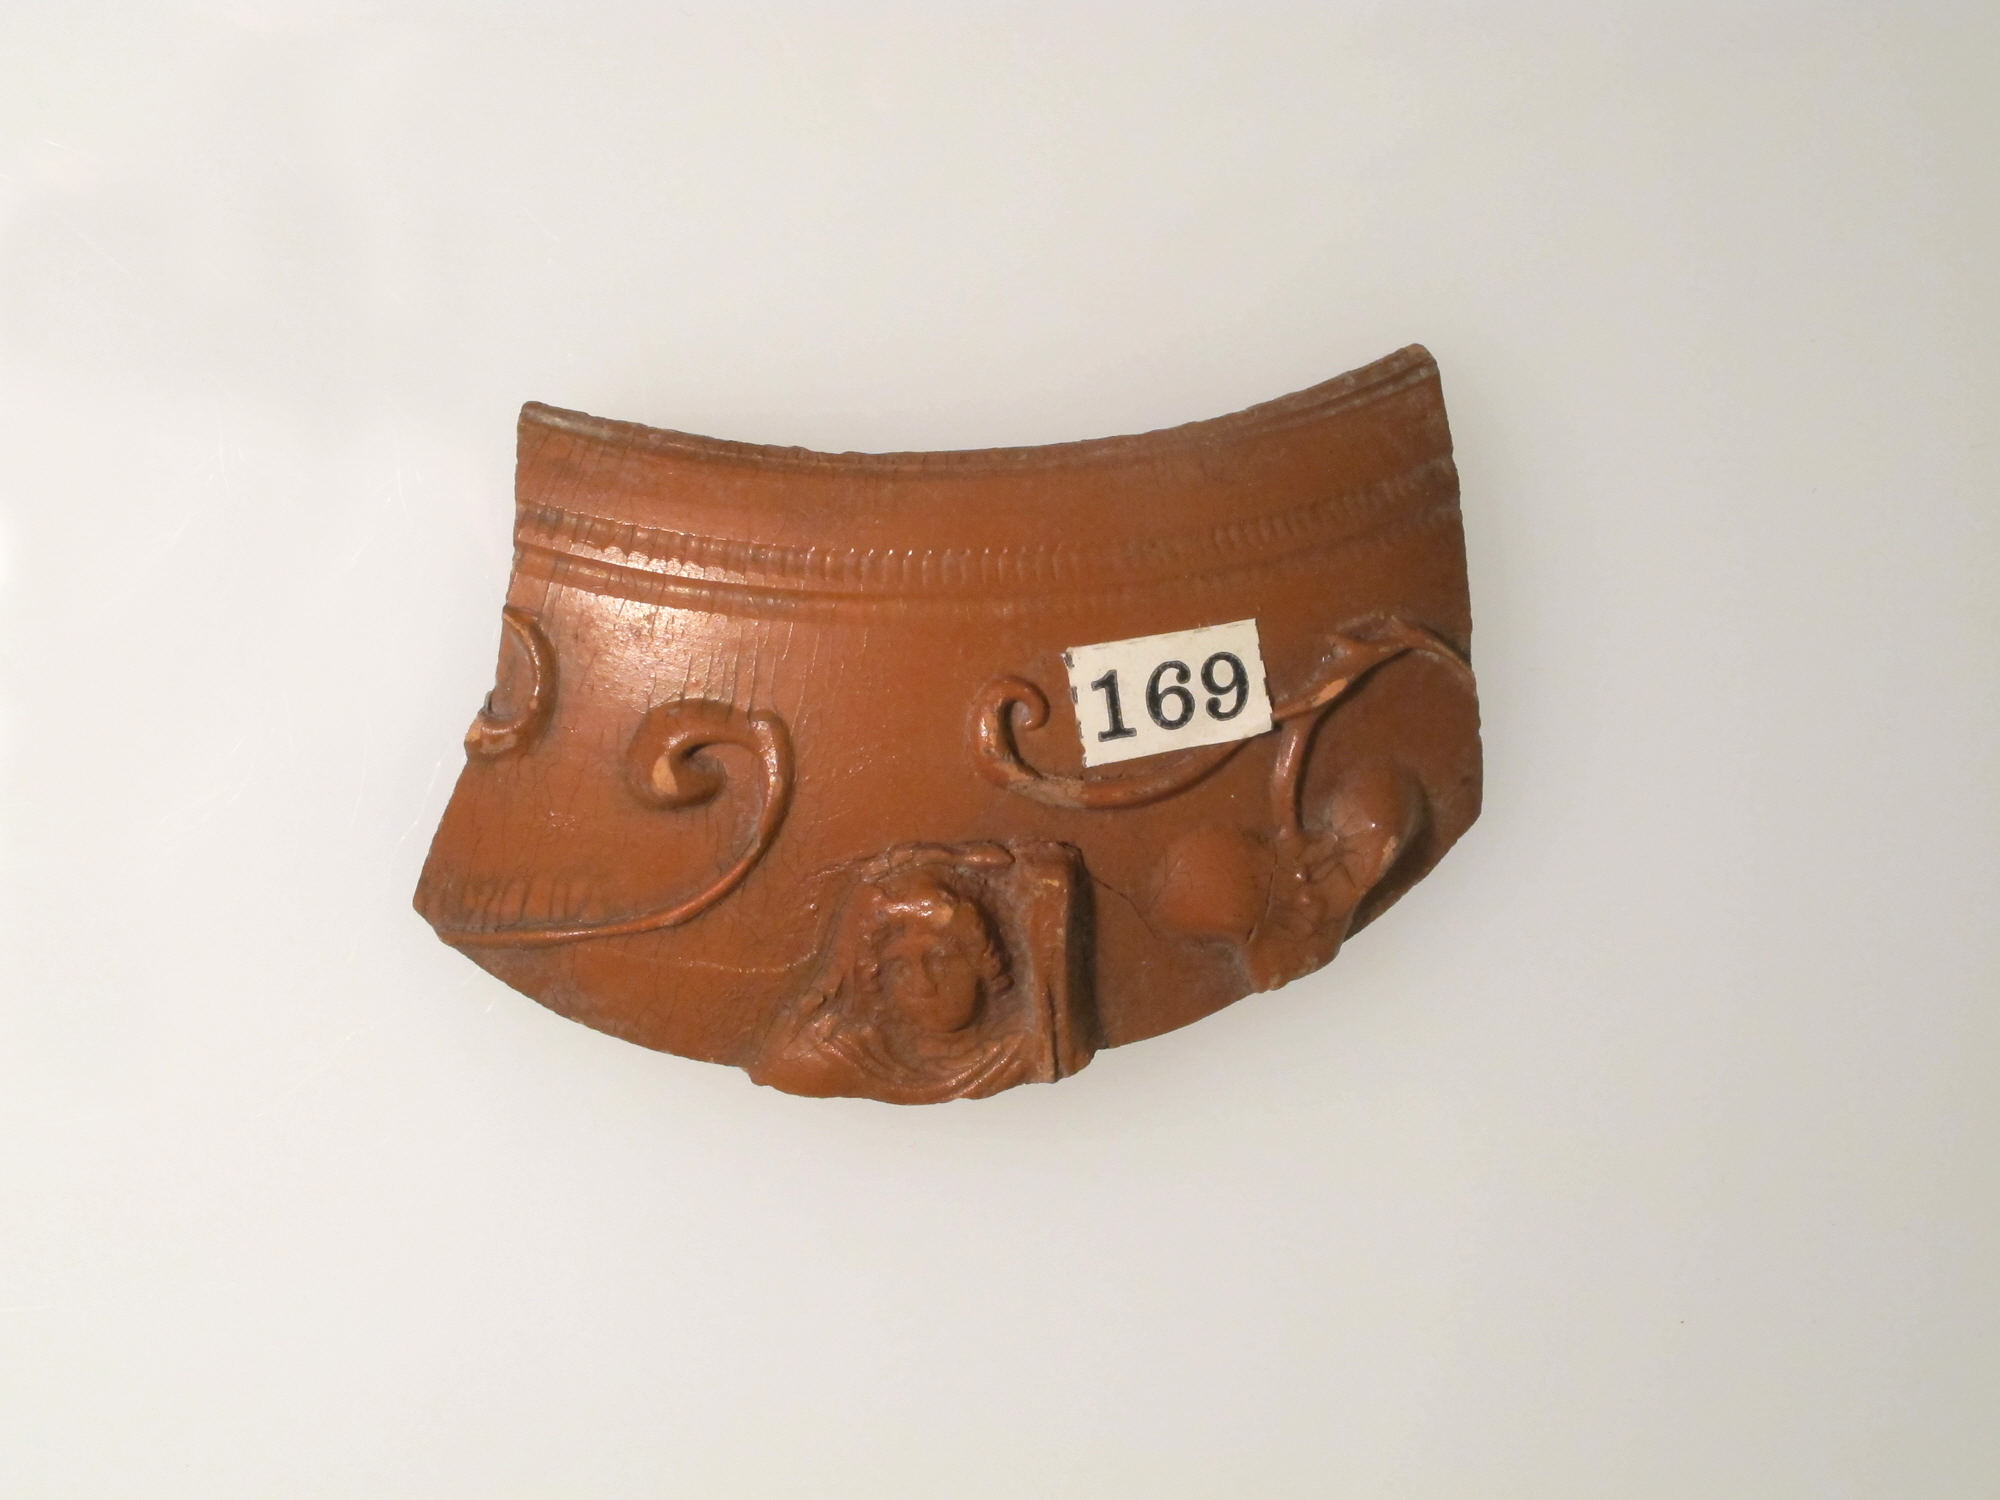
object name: vase fragment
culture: roman, gaul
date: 120 BCE-300 CE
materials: terracotta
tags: heads,women